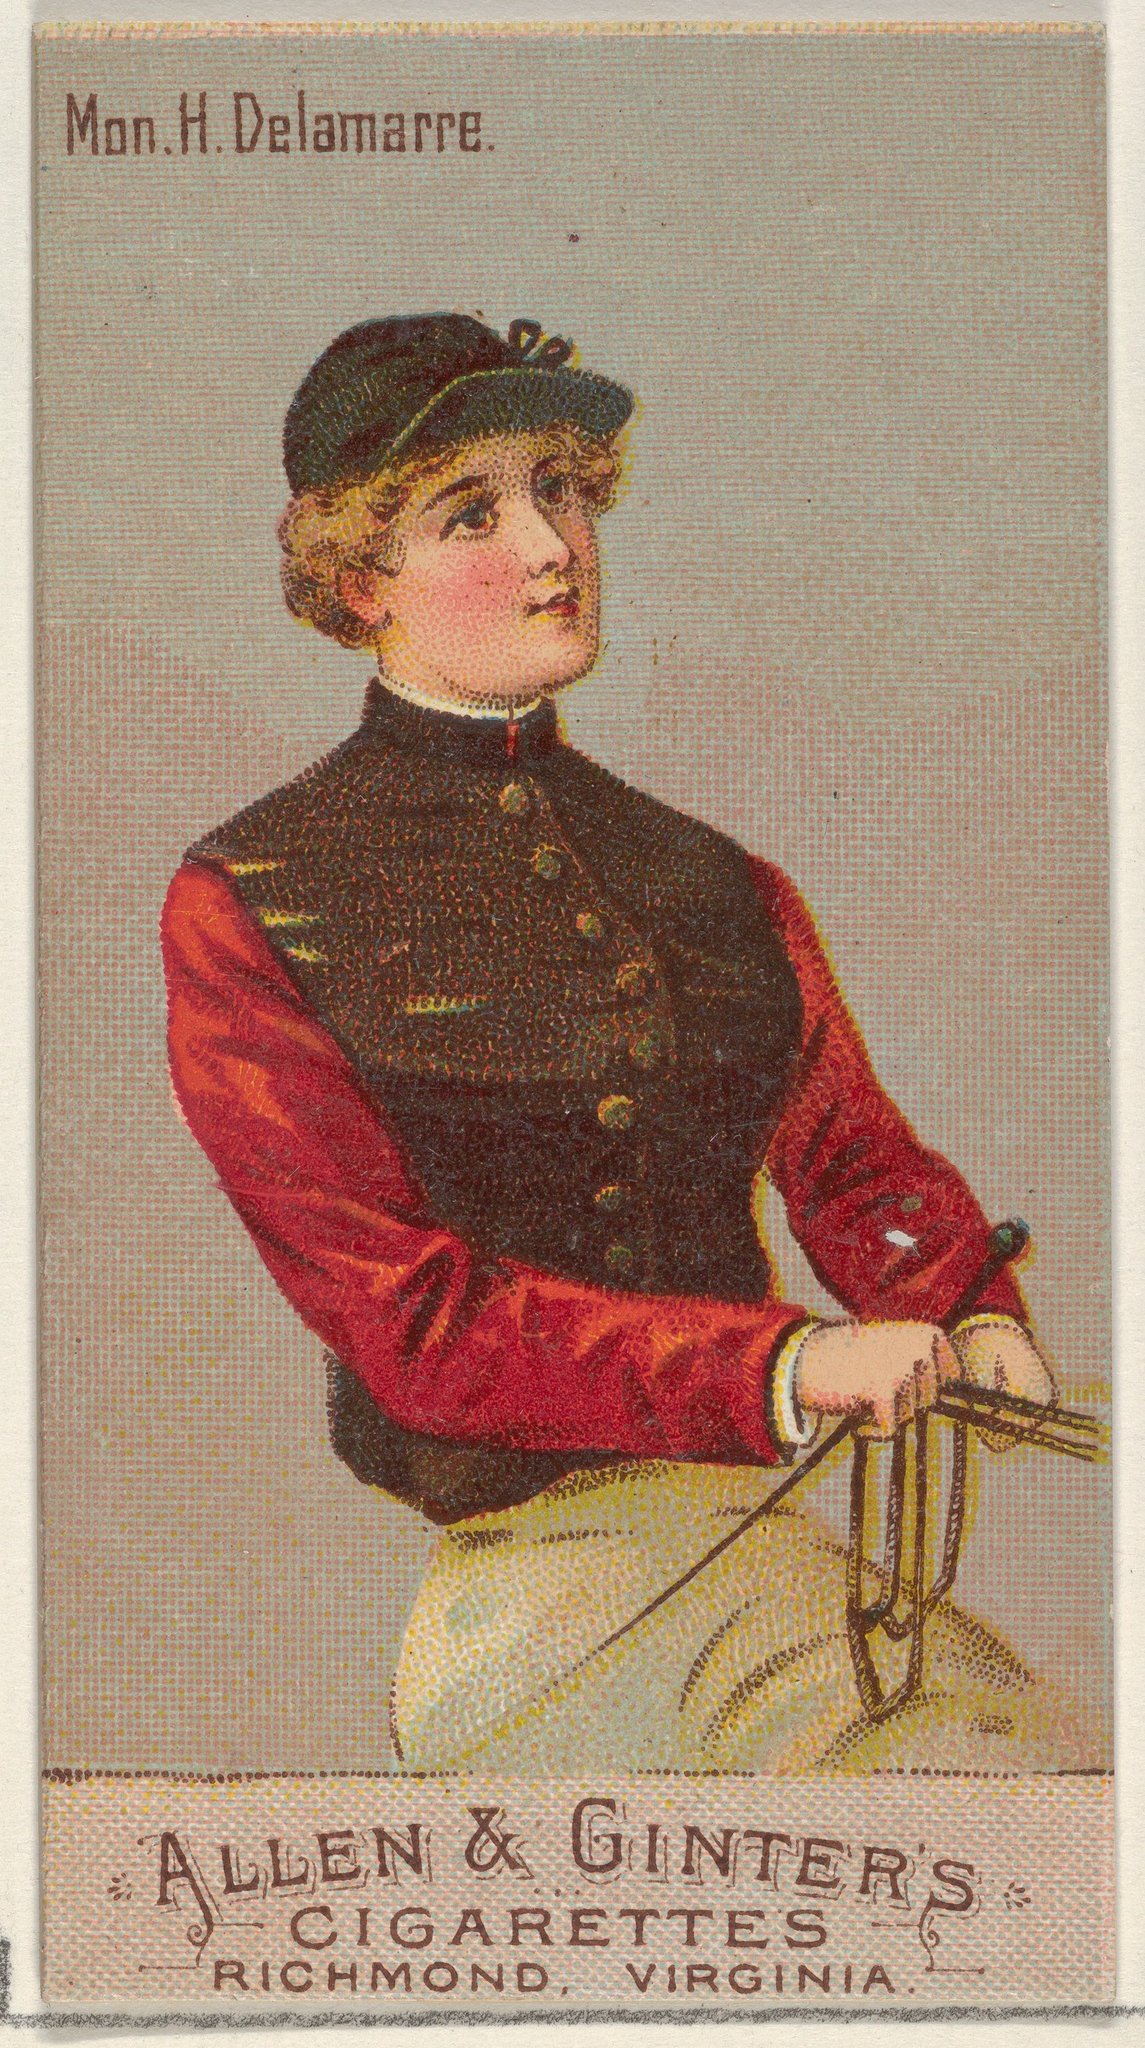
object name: print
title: Mon. H. Delamarre, from the Racing Colors of the World series (N22b) for Allen & Ginter Cigarettes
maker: allen & ginter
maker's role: publisher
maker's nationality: american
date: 1888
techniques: color lithograph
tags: women,jockeys